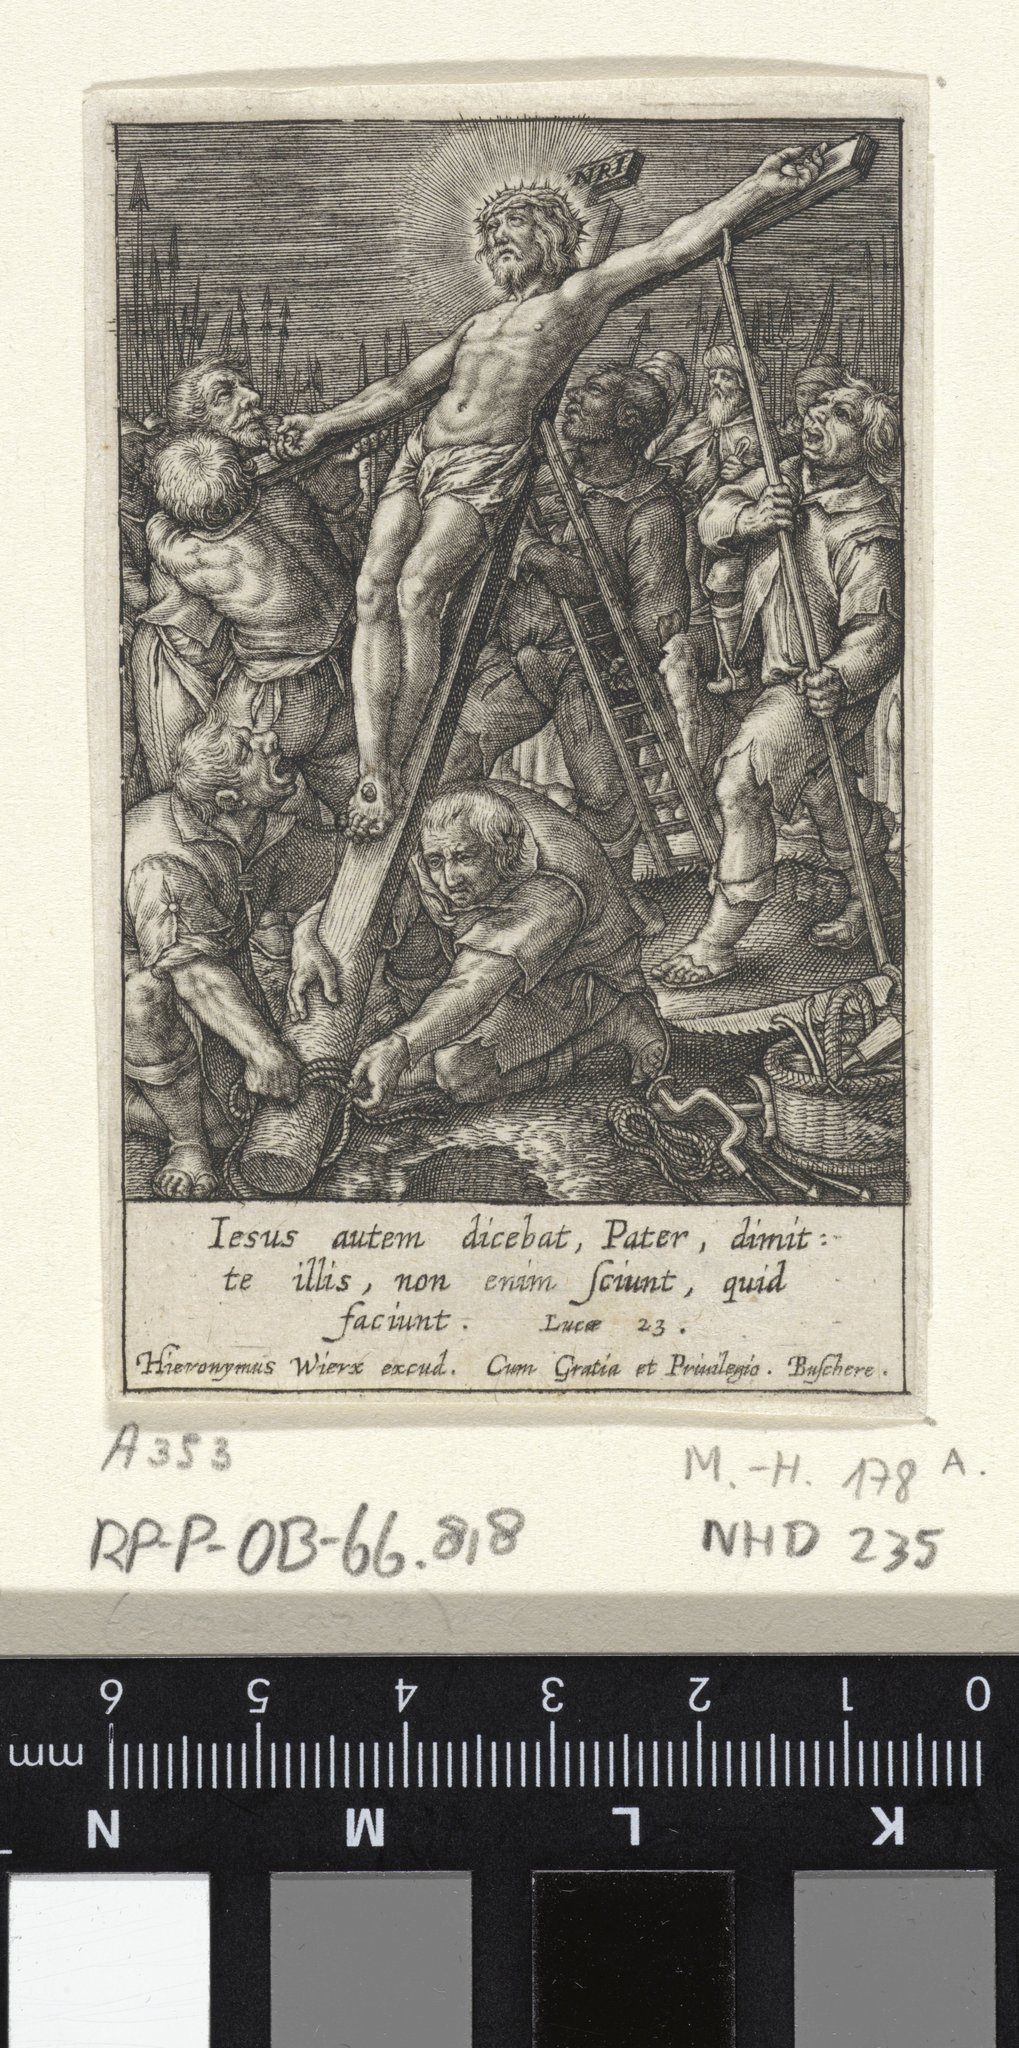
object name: print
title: Passie van Christus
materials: paper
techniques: engraving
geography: antwerp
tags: the erection of the cross: raising of the cross (without christ)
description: Christus is aan het kruis genageld. Enkele soldaten hebben het kruis vast en zetten het recht in de grond. In de marge een drieregelig Bijbelcitaat uit Luc. 23 in het Latijn.